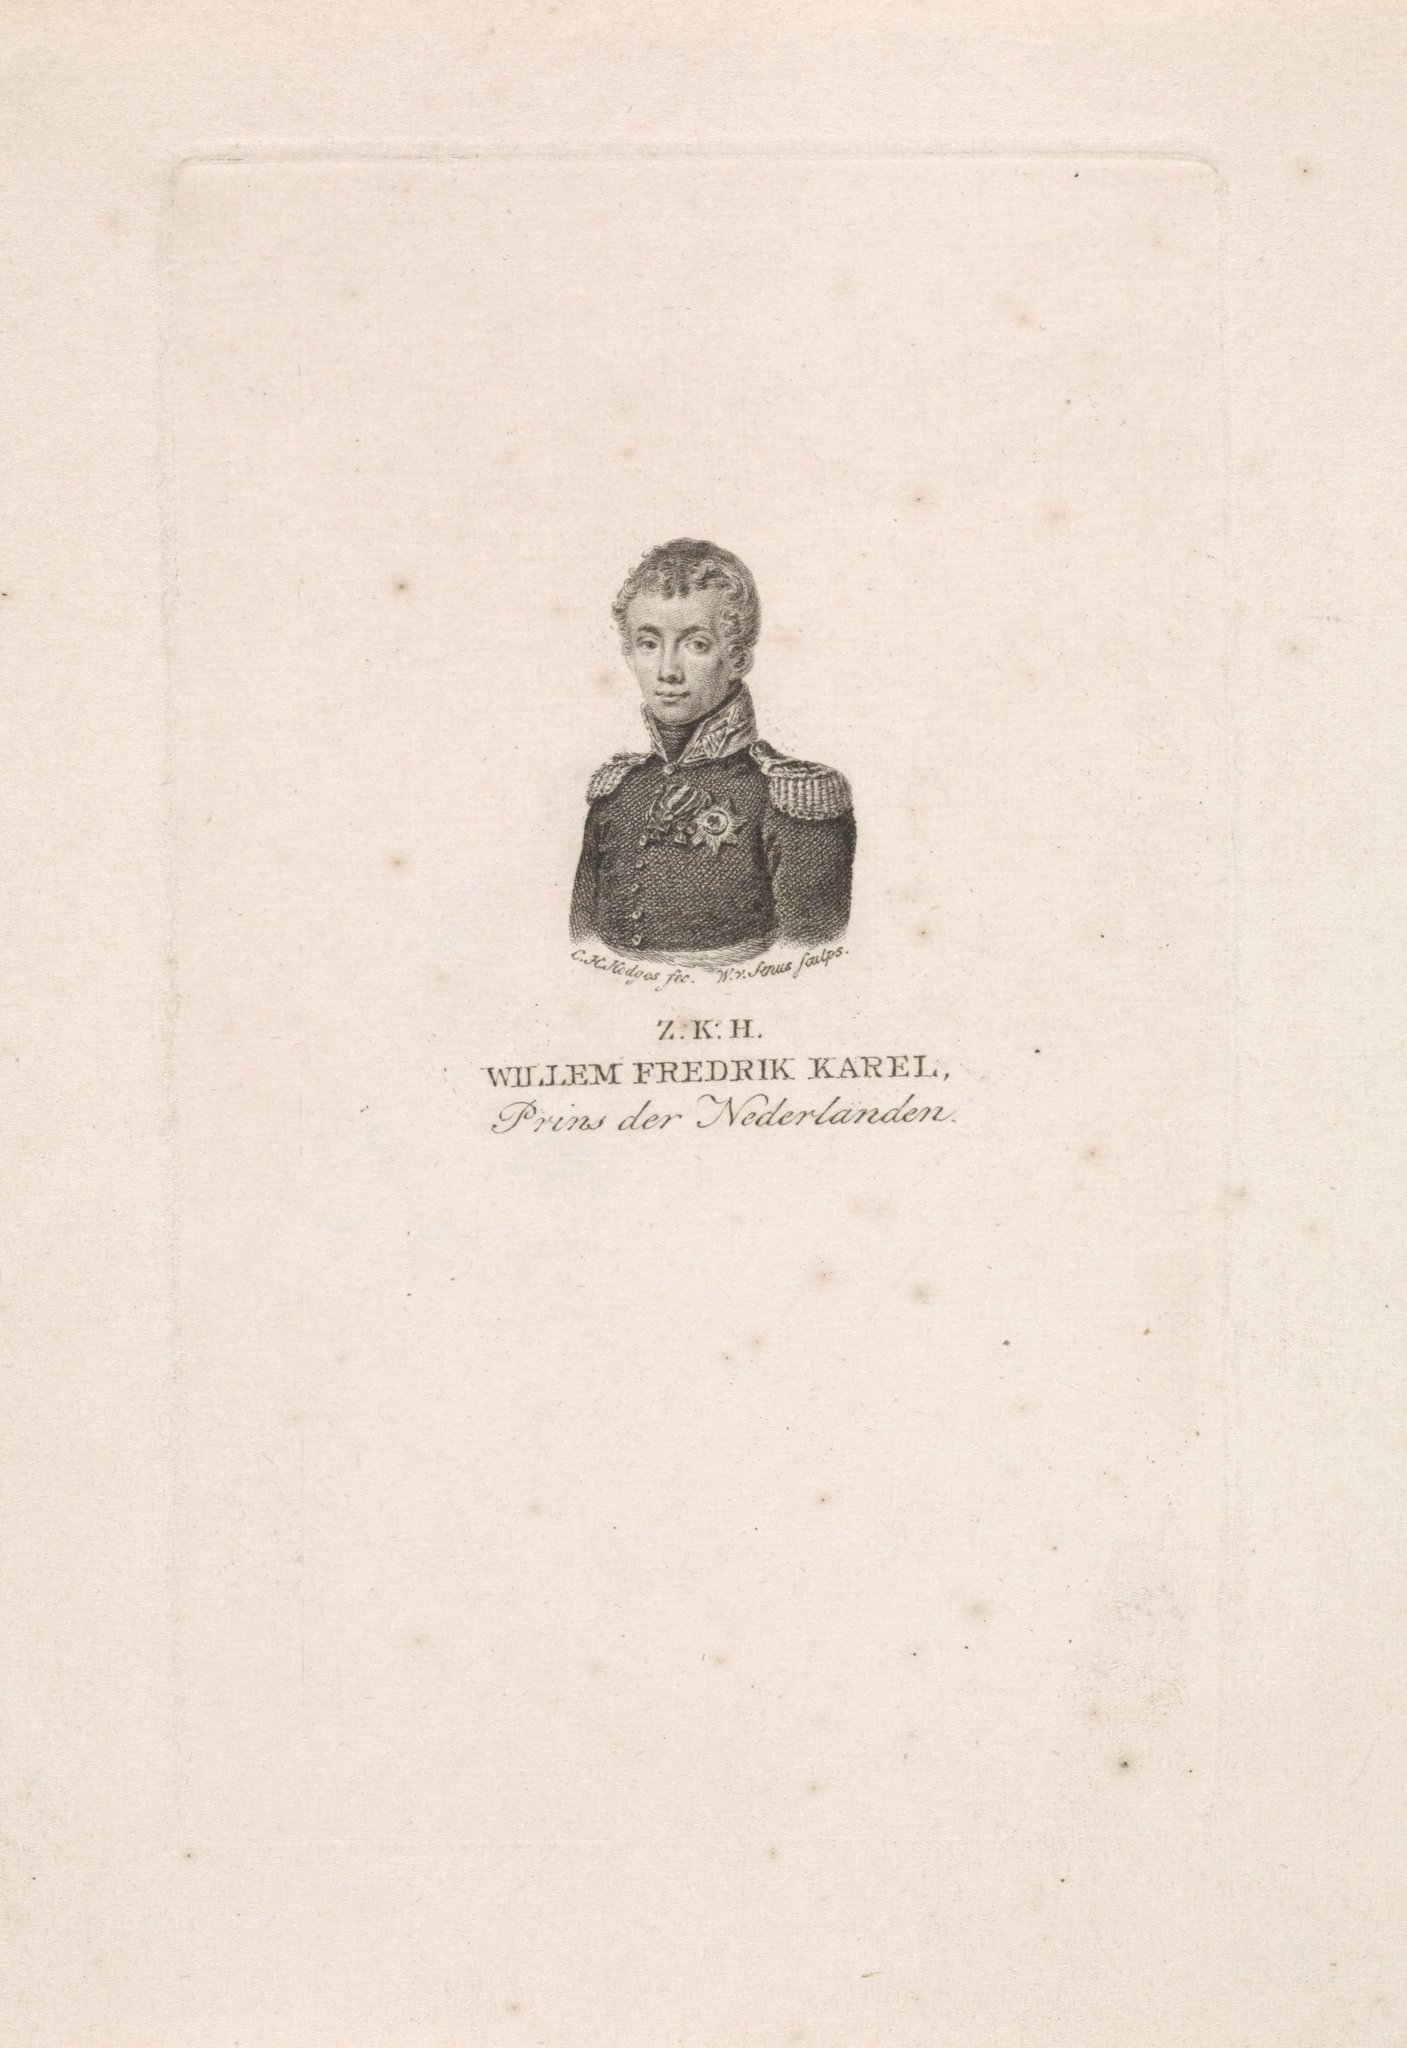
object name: print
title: Portret van Frederik (prins der Nederlanden)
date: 1807-1851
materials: paper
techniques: etching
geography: netherlands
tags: berlin, frederik (prins der nederlanden)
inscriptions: signature and date: ‘r.o. portret: W. v. Senus sculpsit; l.o.: C.H. Hodges fec.’, collector's mark: Lugt 2228, inscription: ‘m.o.: Z.K.H. WILLEM FREDERIK KAREL, Prins der Nederlanden’